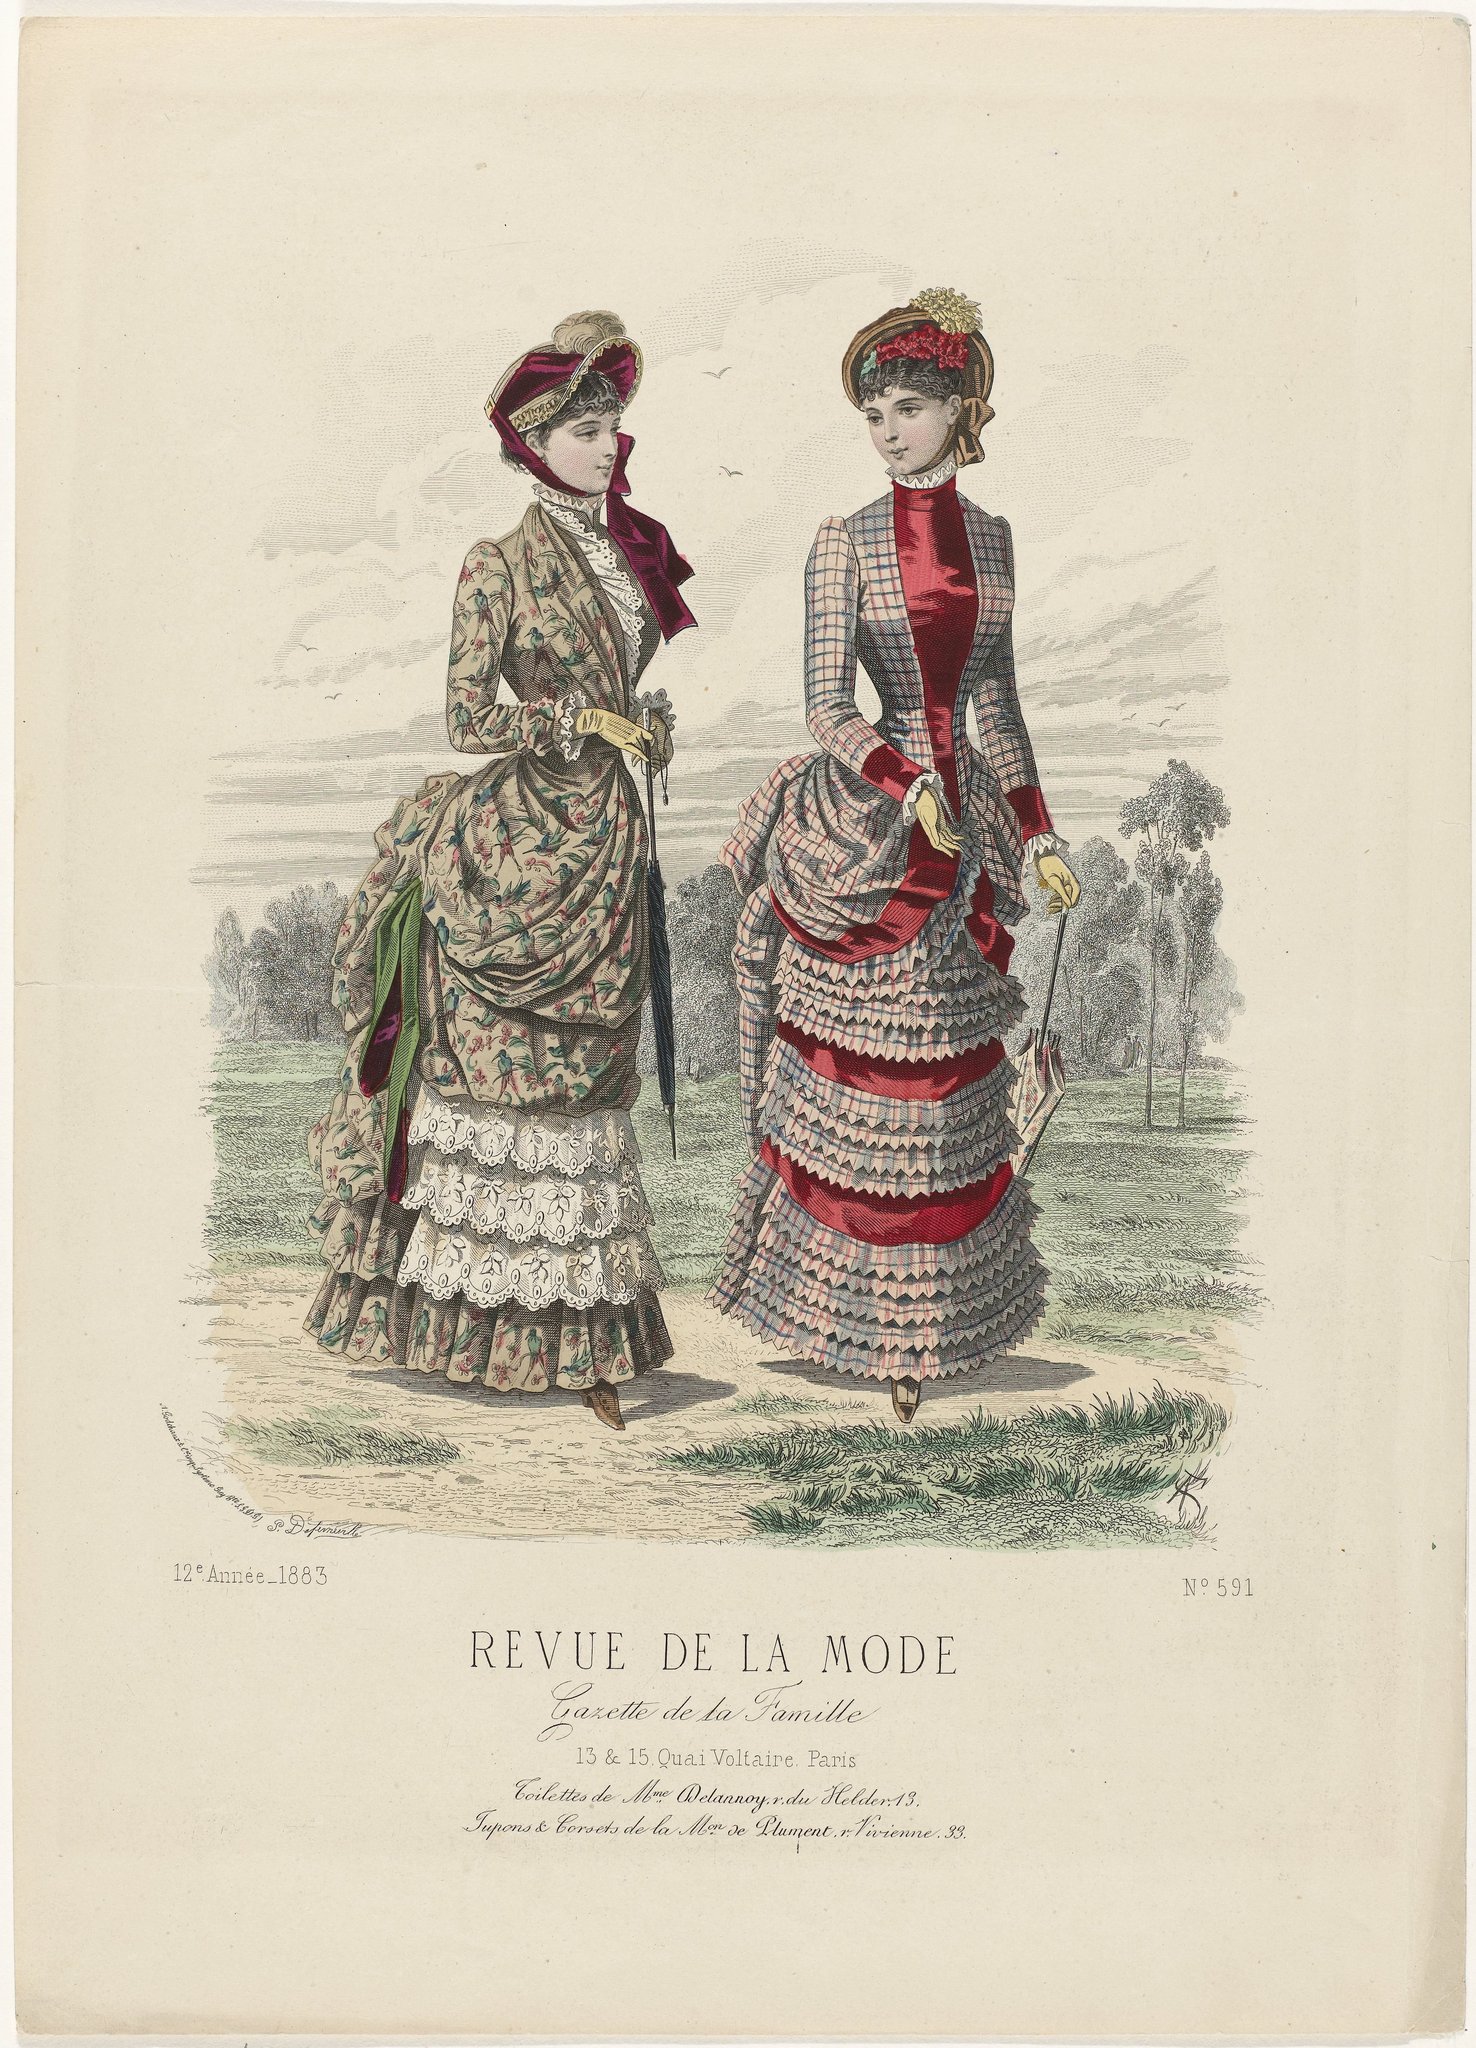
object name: fashion print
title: Revue de la Mode, Gazette de la Famille, dimanche 29 Avril 1883, 12e annee, No. 591: Toilettes de M.me Delannoy (...)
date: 1883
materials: paper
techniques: engraving, hand coloring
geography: paris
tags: dress, gown: walking dress (+ women's clothes), dress, gown (visiting dress) (+ women's clothes), fashion plates, head-gear: hat (+ women's clothes)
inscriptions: address: ‘13 & 15, Quai Voltaire Paris’, title: ‘REVUE DE LA MODE / Gazette de la Famille’, caption: ‘Toilettes de M.me Delannoy, r. du Helder, 13. Jupons & Corsets de la Mo.n de Plument, r. Vivienne, 33.’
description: Twee vrouwen, in japonnen van Delannoy, wandelend in een park. Links: japon voor wandelingen en 'visite' van beige bedrukte foulard. Rechts: japon voor wandelingen en 'visite' van geruite changeant tafzijde en effen rood velours. Onderschrift met een regel reclametekst voor verschillende producten. Prent uit het modetijdschrift Revue de la Mode (1872-1913). Uitgebreide beschrijving van de kleding op pagina 131 "PLANCHE COLORIÉE".